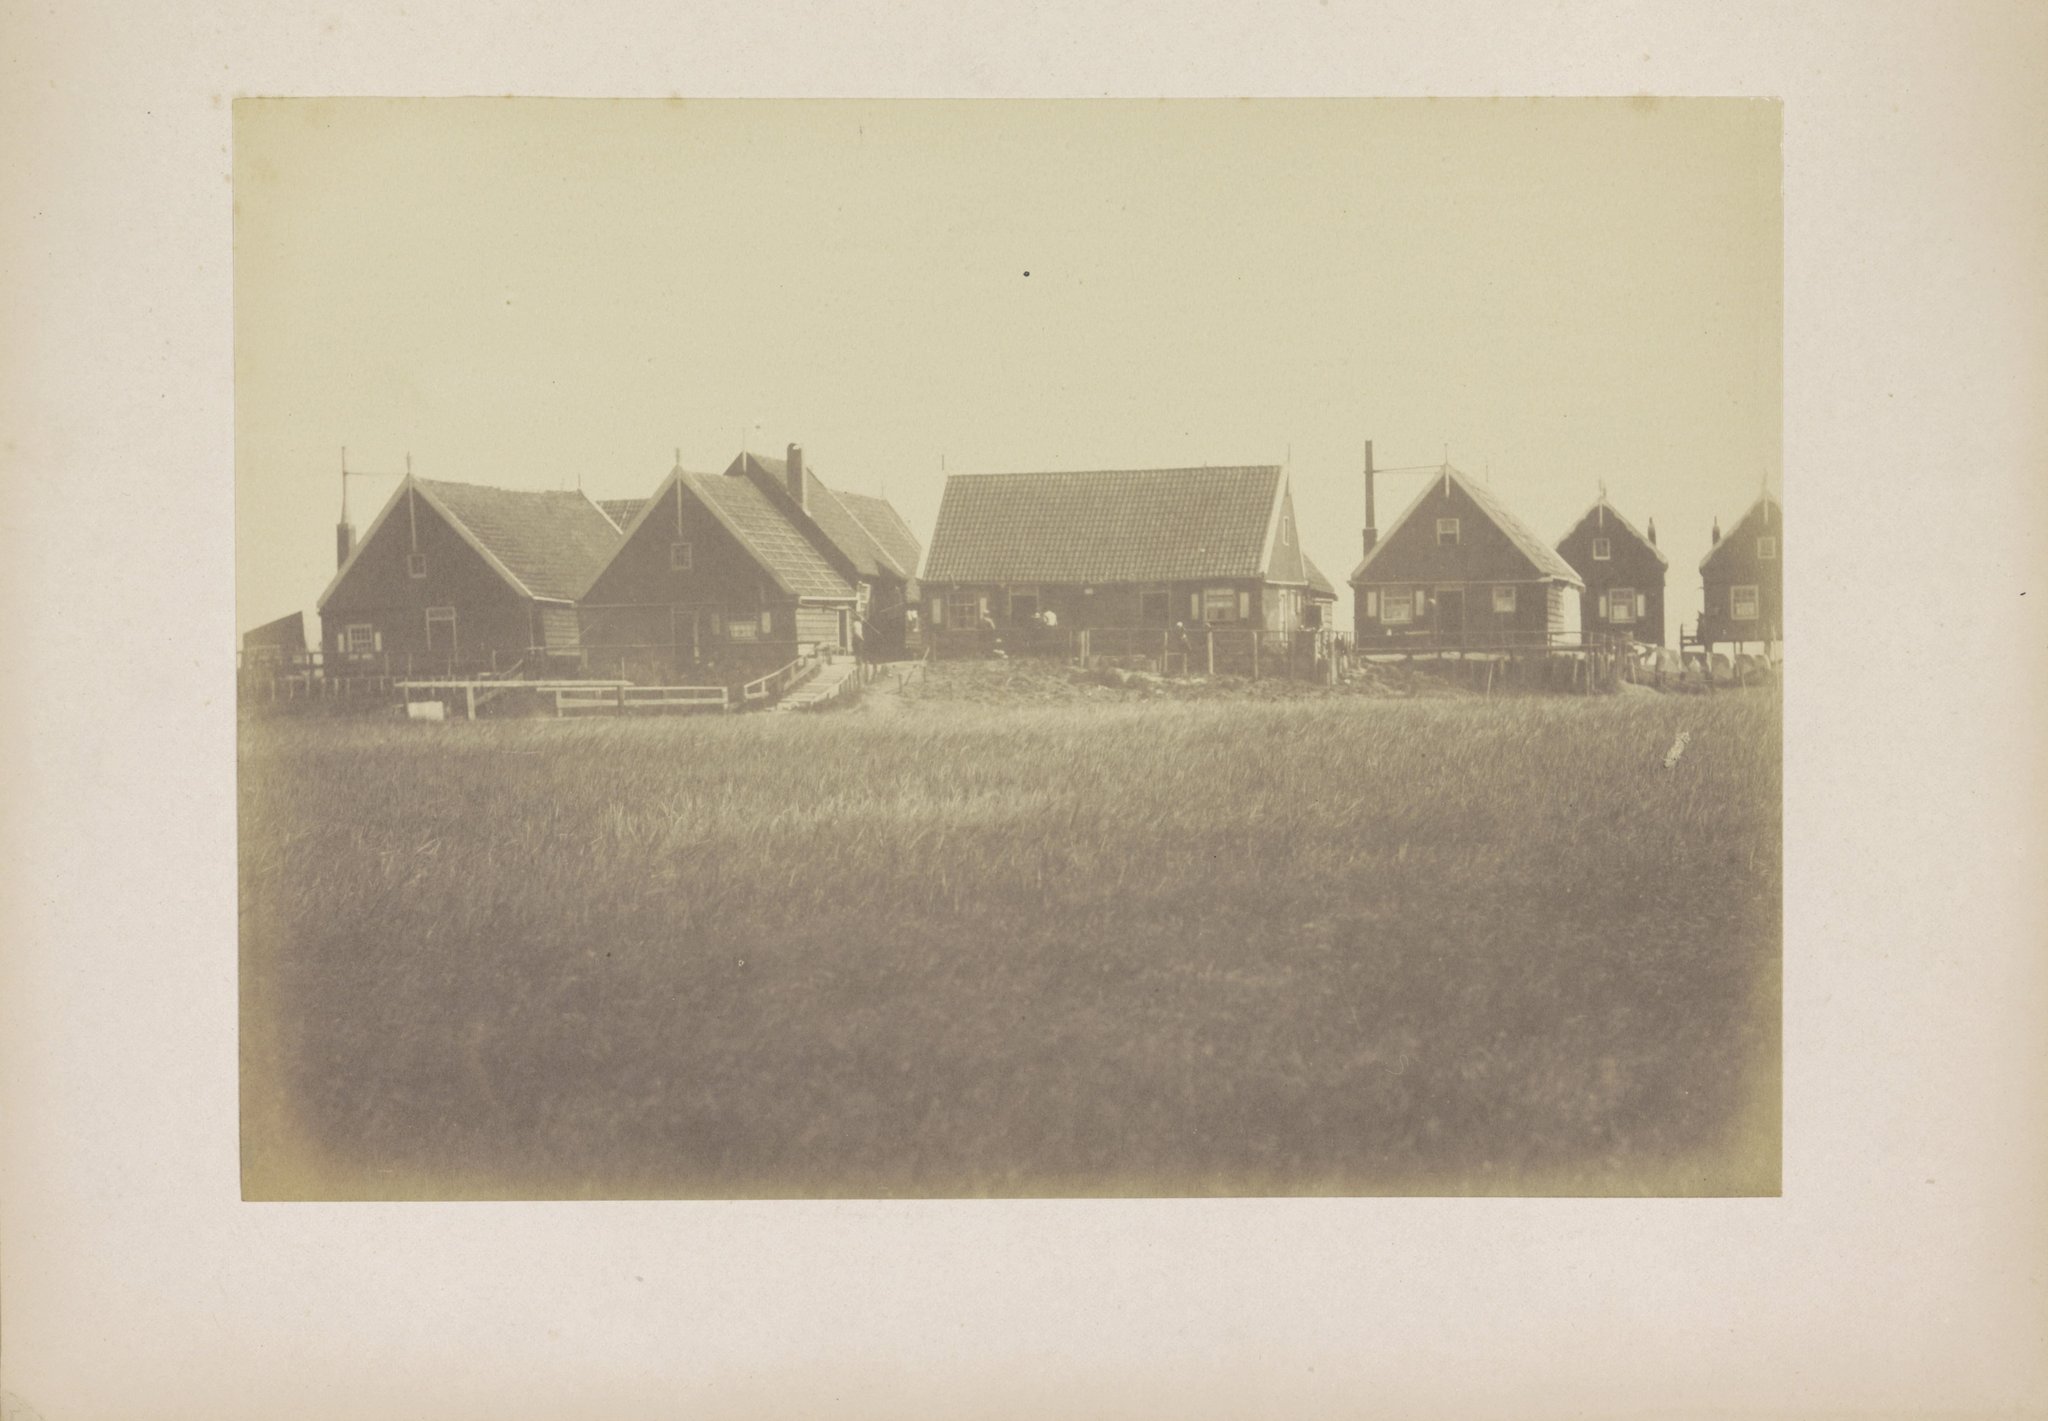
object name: photograph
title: Huizen op het eiland Marken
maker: Anonymous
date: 1885-1900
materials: paper, photographic support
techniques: albumen print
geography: france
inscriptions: annotation: ‘(Hollande)’